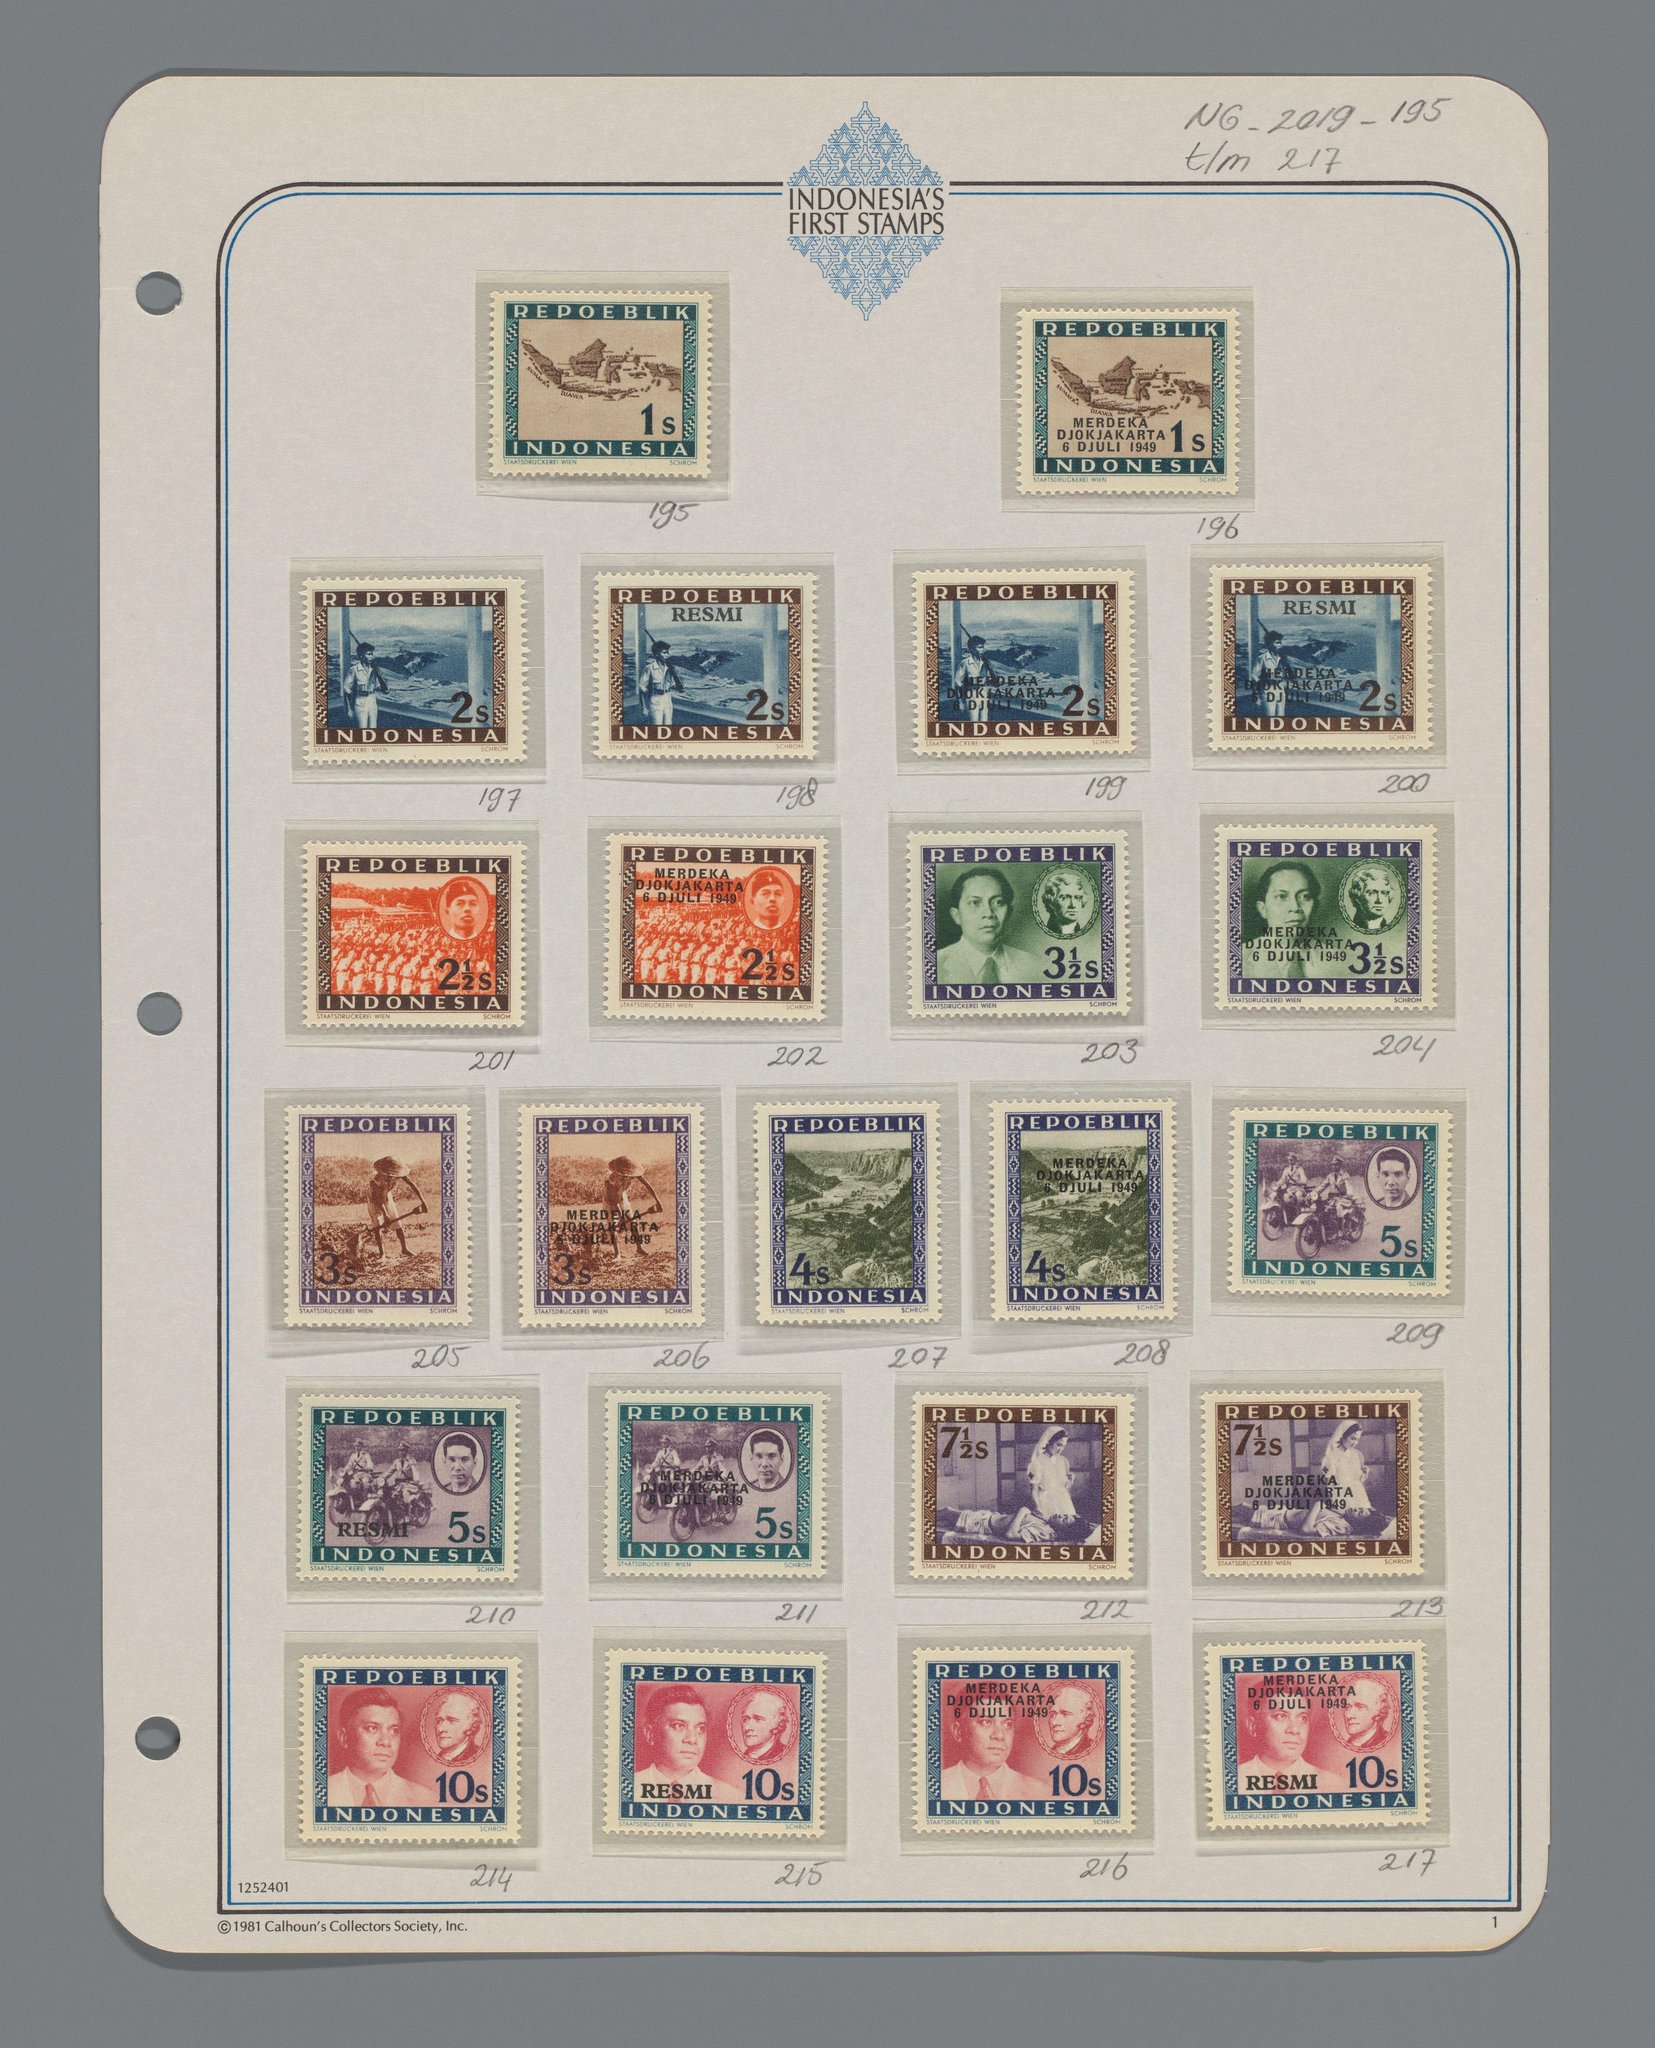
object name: postage stamp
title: Postzegel Republik Indonesia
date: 1949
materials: paper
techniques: photoaquatint, engraving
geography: vienna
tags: indonesia